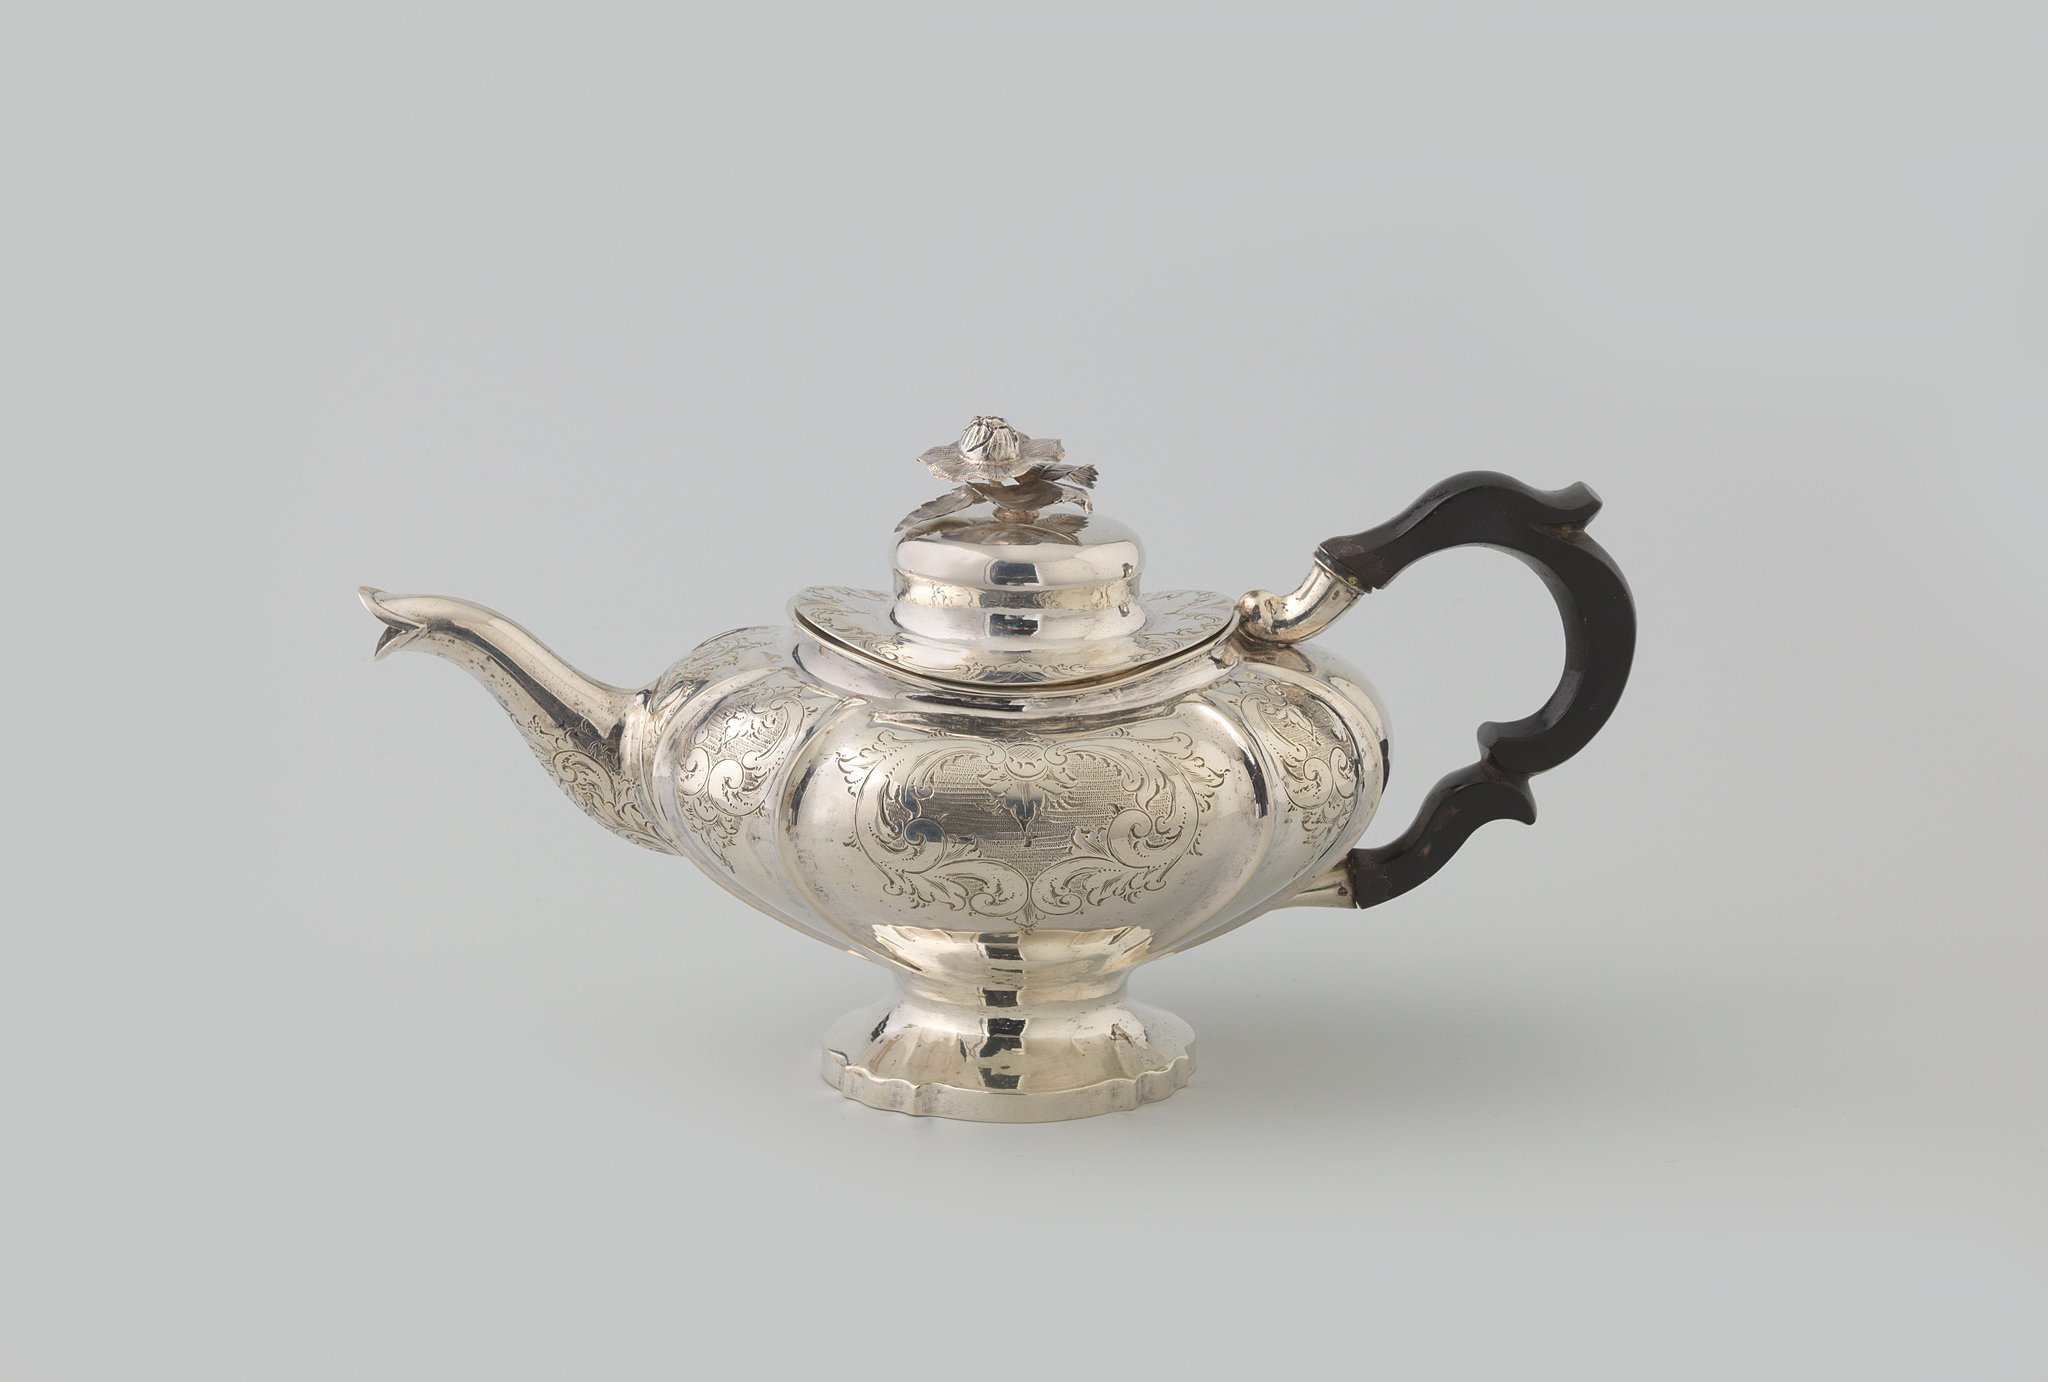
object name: teapot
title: Theepot, ovaal met acht ribben, gegraveerd met C-voluten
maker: johannes mulder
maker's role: silversmith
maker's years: 1816-1862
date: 1859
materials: silver, wood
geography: amsterdam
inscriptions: date letter: ‘Z’, hallmark, maker's mark, assay office mark, alloy mark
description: De ovale theepot rust op een rechtwandige, gecontourneerde basis. Daarboven rijst de gewelfde, zich verjongende voet op, die het afgeplat bolvormige vat draagt. Dit is door acht verticale ribben in vakken verdeeld, die ieder zijn gegraveerd met een symmetrisch, uit C-voluten opgebouwd ornament. Aan de bovenzijde van het vat bevindt zich een ovale opening met een opstaande rand. Hierin past het losse, gedrukt bolvormige deksel met uitspreidende rand, die is gegraveerd met een symmetrisch patroon van C-voluten. Het deksel wordt bekroond door een knop in de vorm van een bloemtakje. De theepot heeft een S-vormig gebogen tuit, die aan de onderzijde is gegraveerd met C-voluten en rocailles, en een uit een S- en een C-voluut samengesteld gezwart houten oor, dat met de pot is verbonden door twee zilveren vattingen, de bovenste in de vorm van een C-voluut, de onderste uitlopend in een punt.